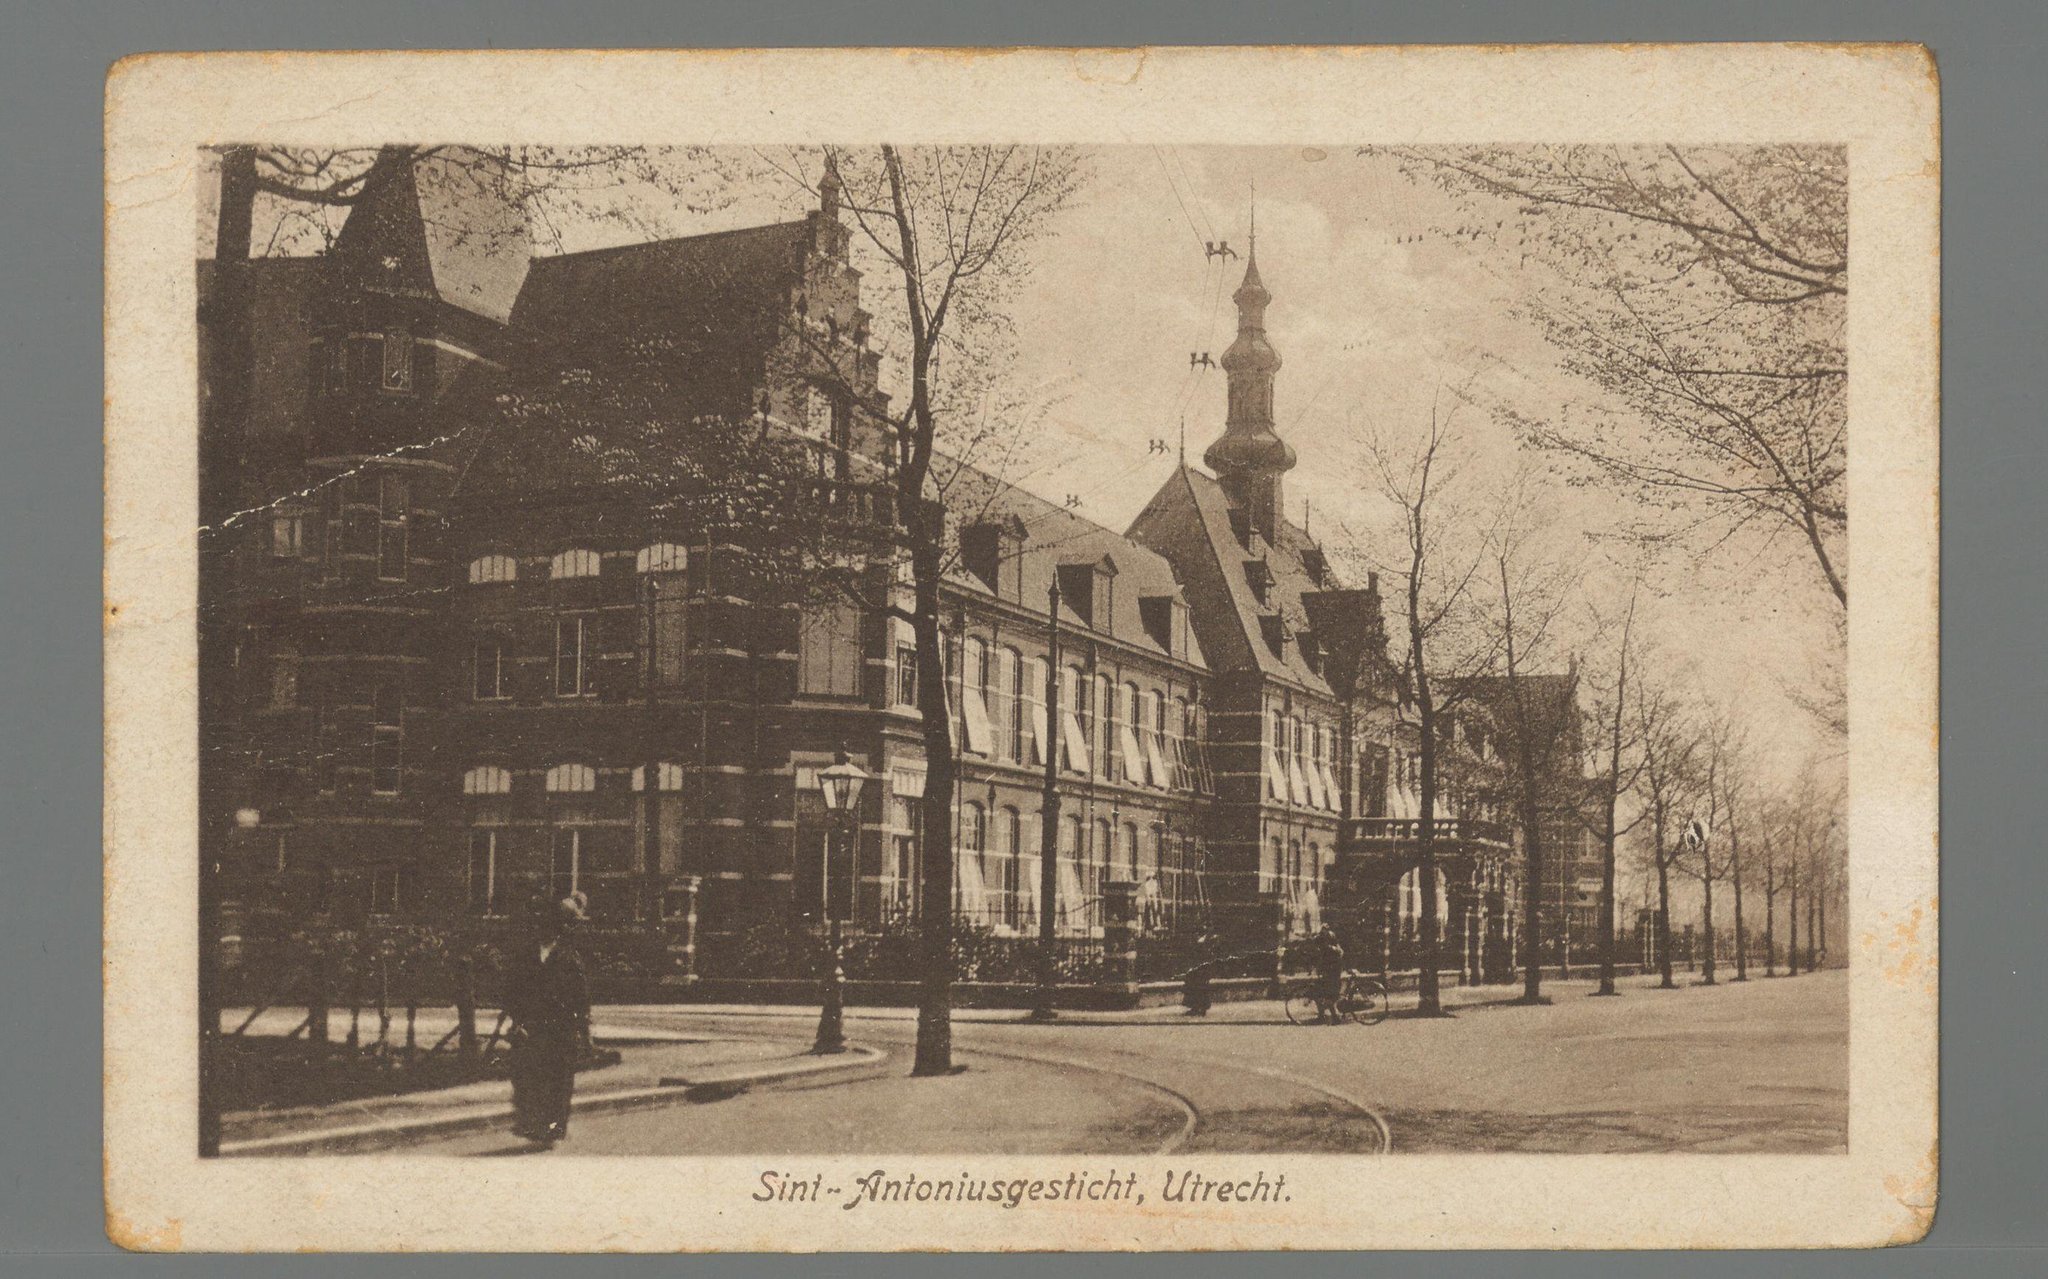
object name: photomechanical print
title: Sint-Antoniusgesticht, Utrecht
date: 1913-1925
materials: cardboard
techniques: photograph, writing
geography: utrecht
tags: hospital, utrecht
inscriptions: postage stamp